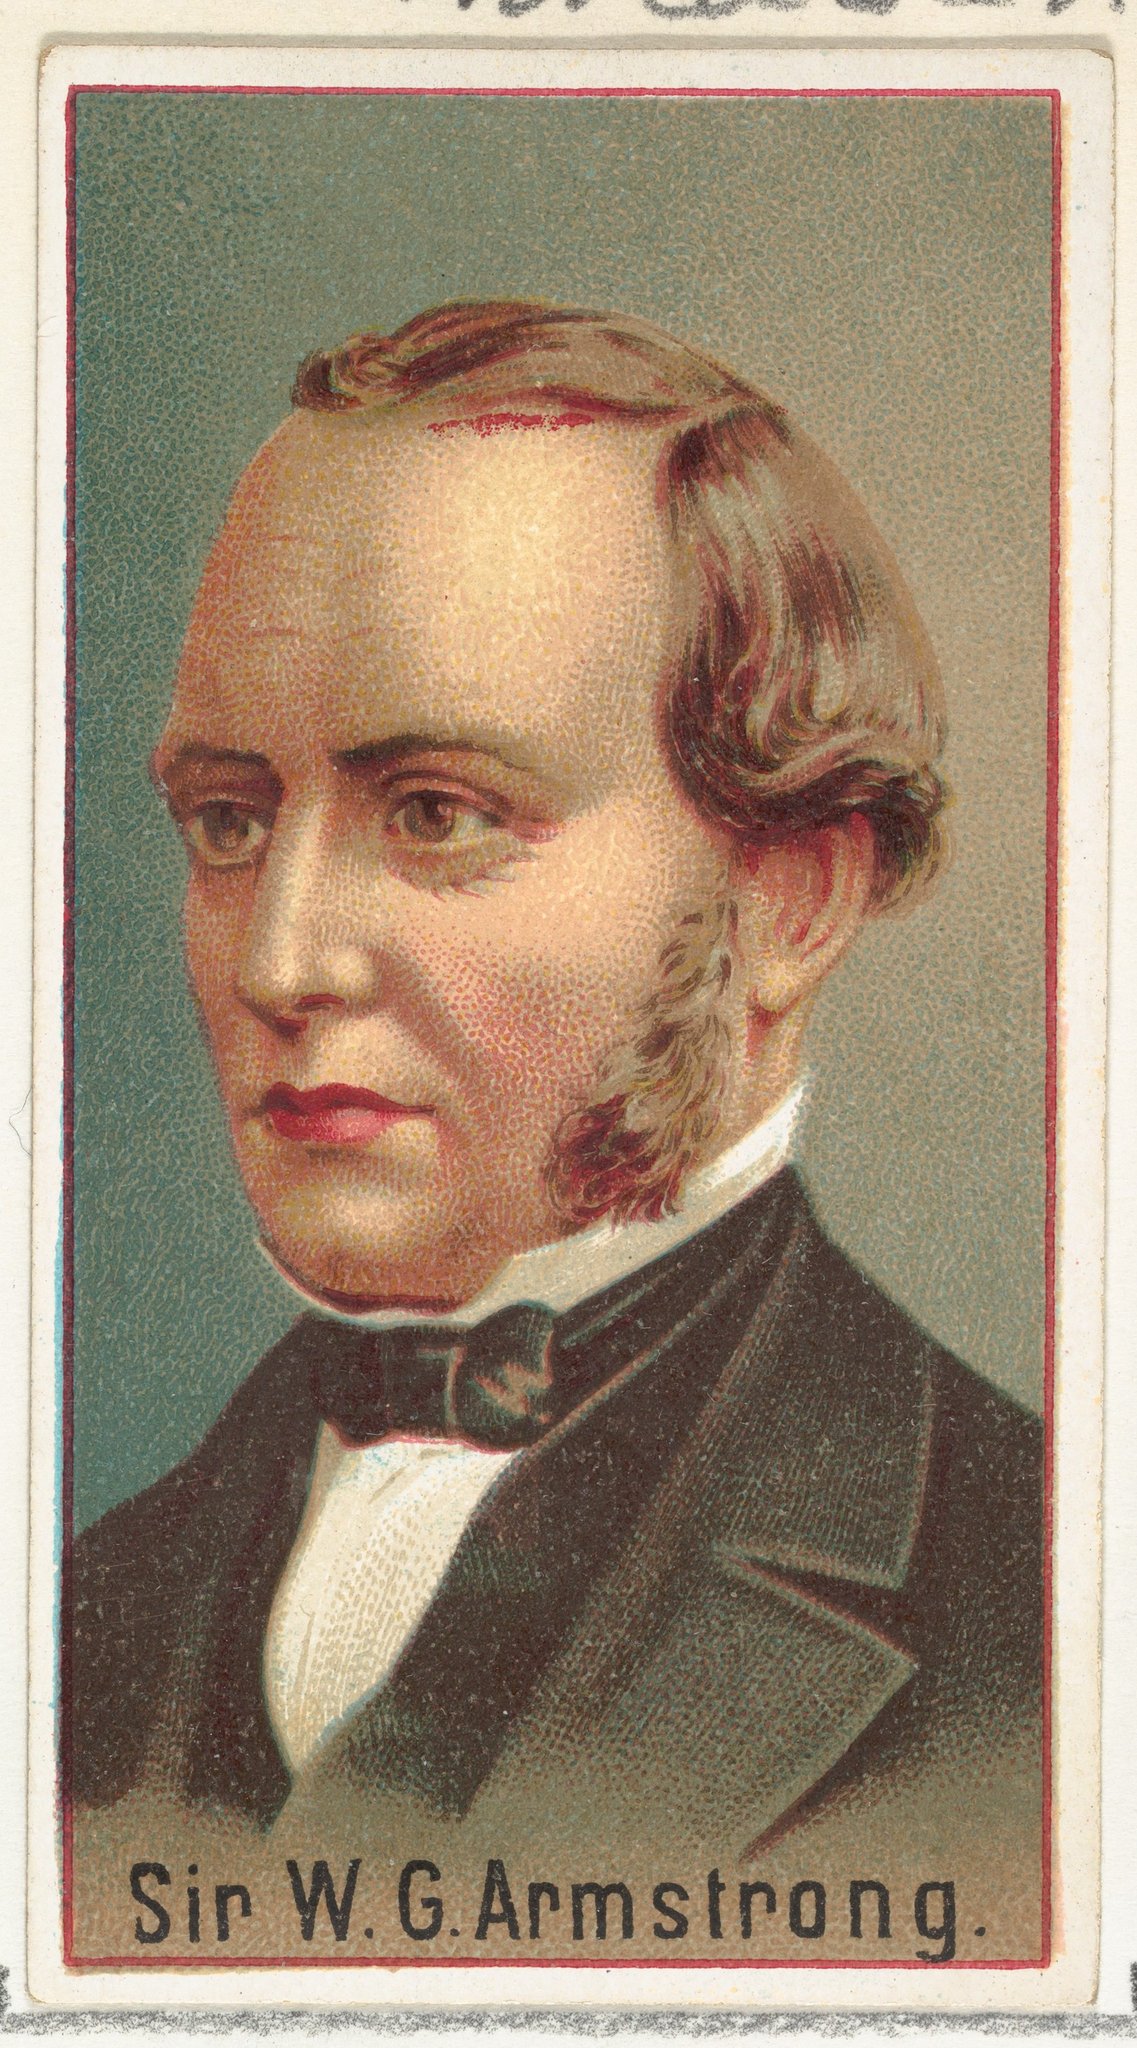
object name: print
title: Sir W. G. Armstrong, printer's sample for the World's Inventors souvenir album (A25) for Allen & Ginter Cigarettes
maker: allen & ginter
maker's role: publisher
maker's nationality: american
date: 1888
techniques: color lithograph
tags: men,portraits